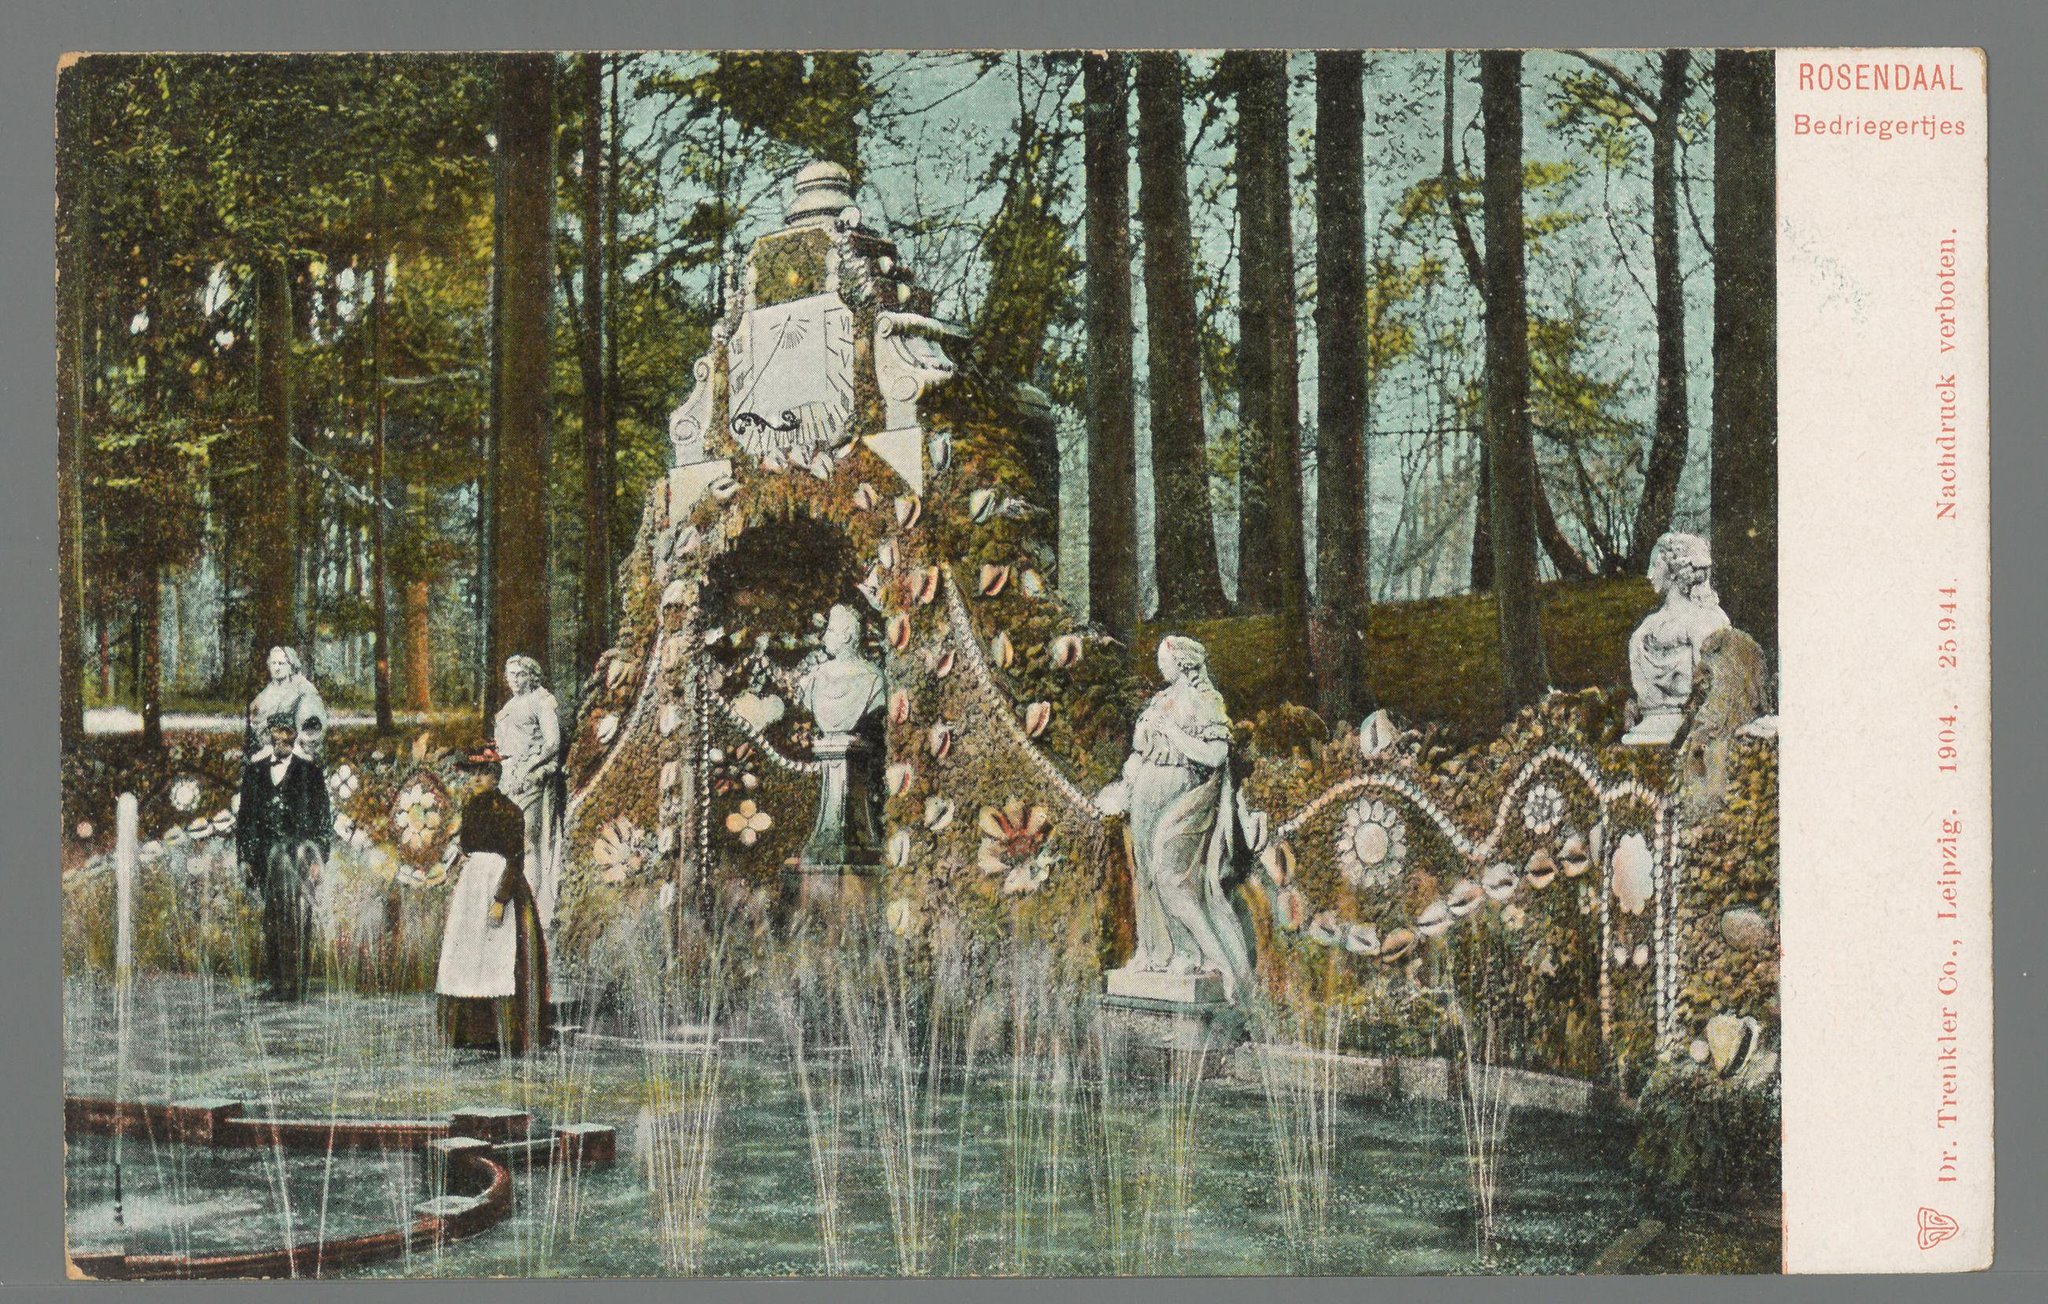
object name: ansichtkaart, prentbriefkaart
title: Rosendaal. Bedriegertjes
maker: Anonymous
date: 1904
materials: cardboard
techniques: lithograph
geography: leipzig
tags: garden fountain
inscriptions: date